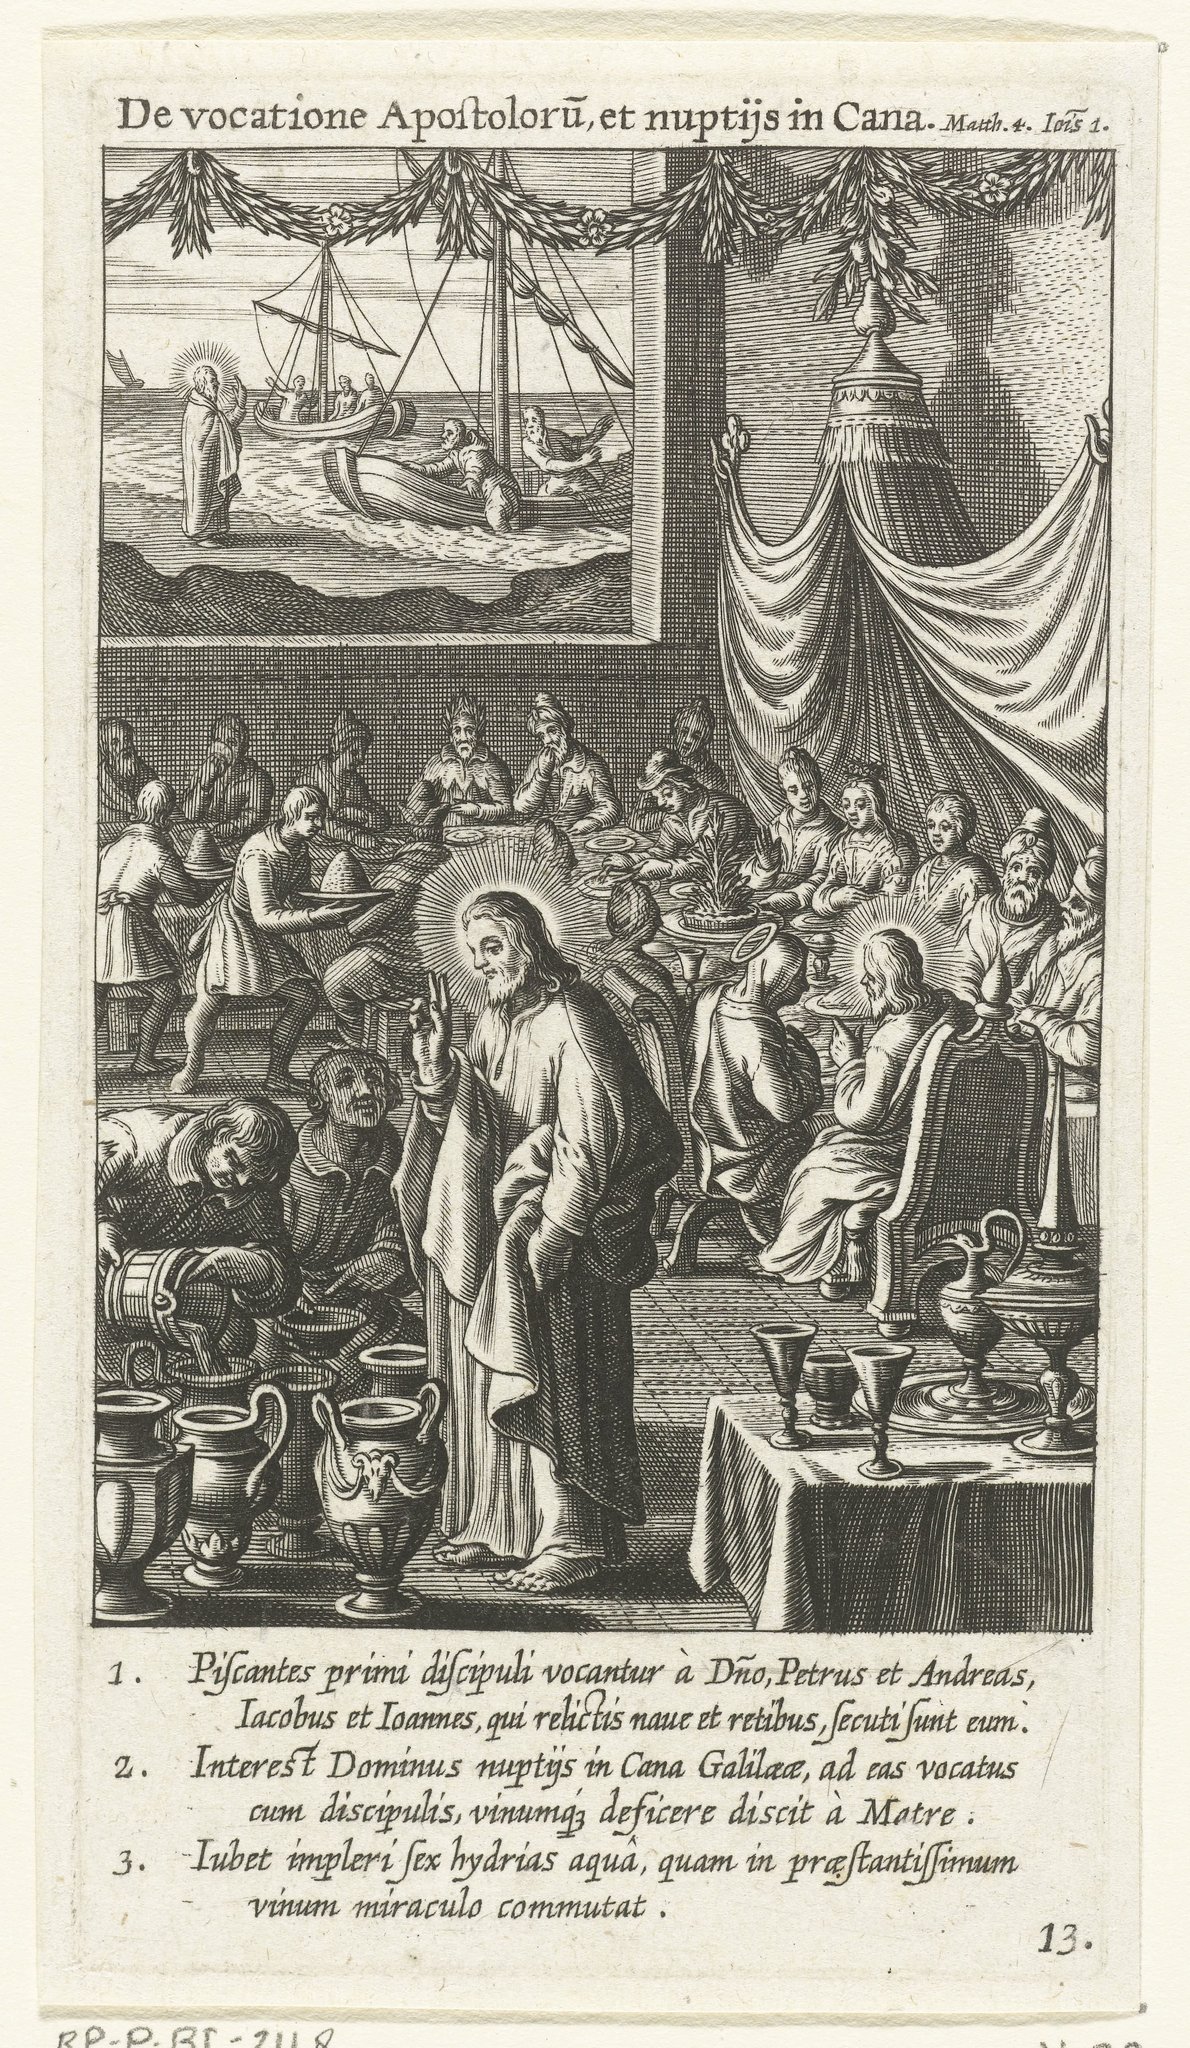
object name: print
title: Bruiloft te Kana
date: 1590-1622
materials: paper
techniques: engraving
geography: antwerp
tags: christ orders (six) jars to be filled with water ~ marriage-feast at cana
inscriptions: collector's mark: Lugt 240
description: Prent uit: Joannes Bourgois, Vitae passionis et mortis Jesu Christi Somini nostri mysteria, Antwerpen Hendrick Aertssens, 1622, afb. 13